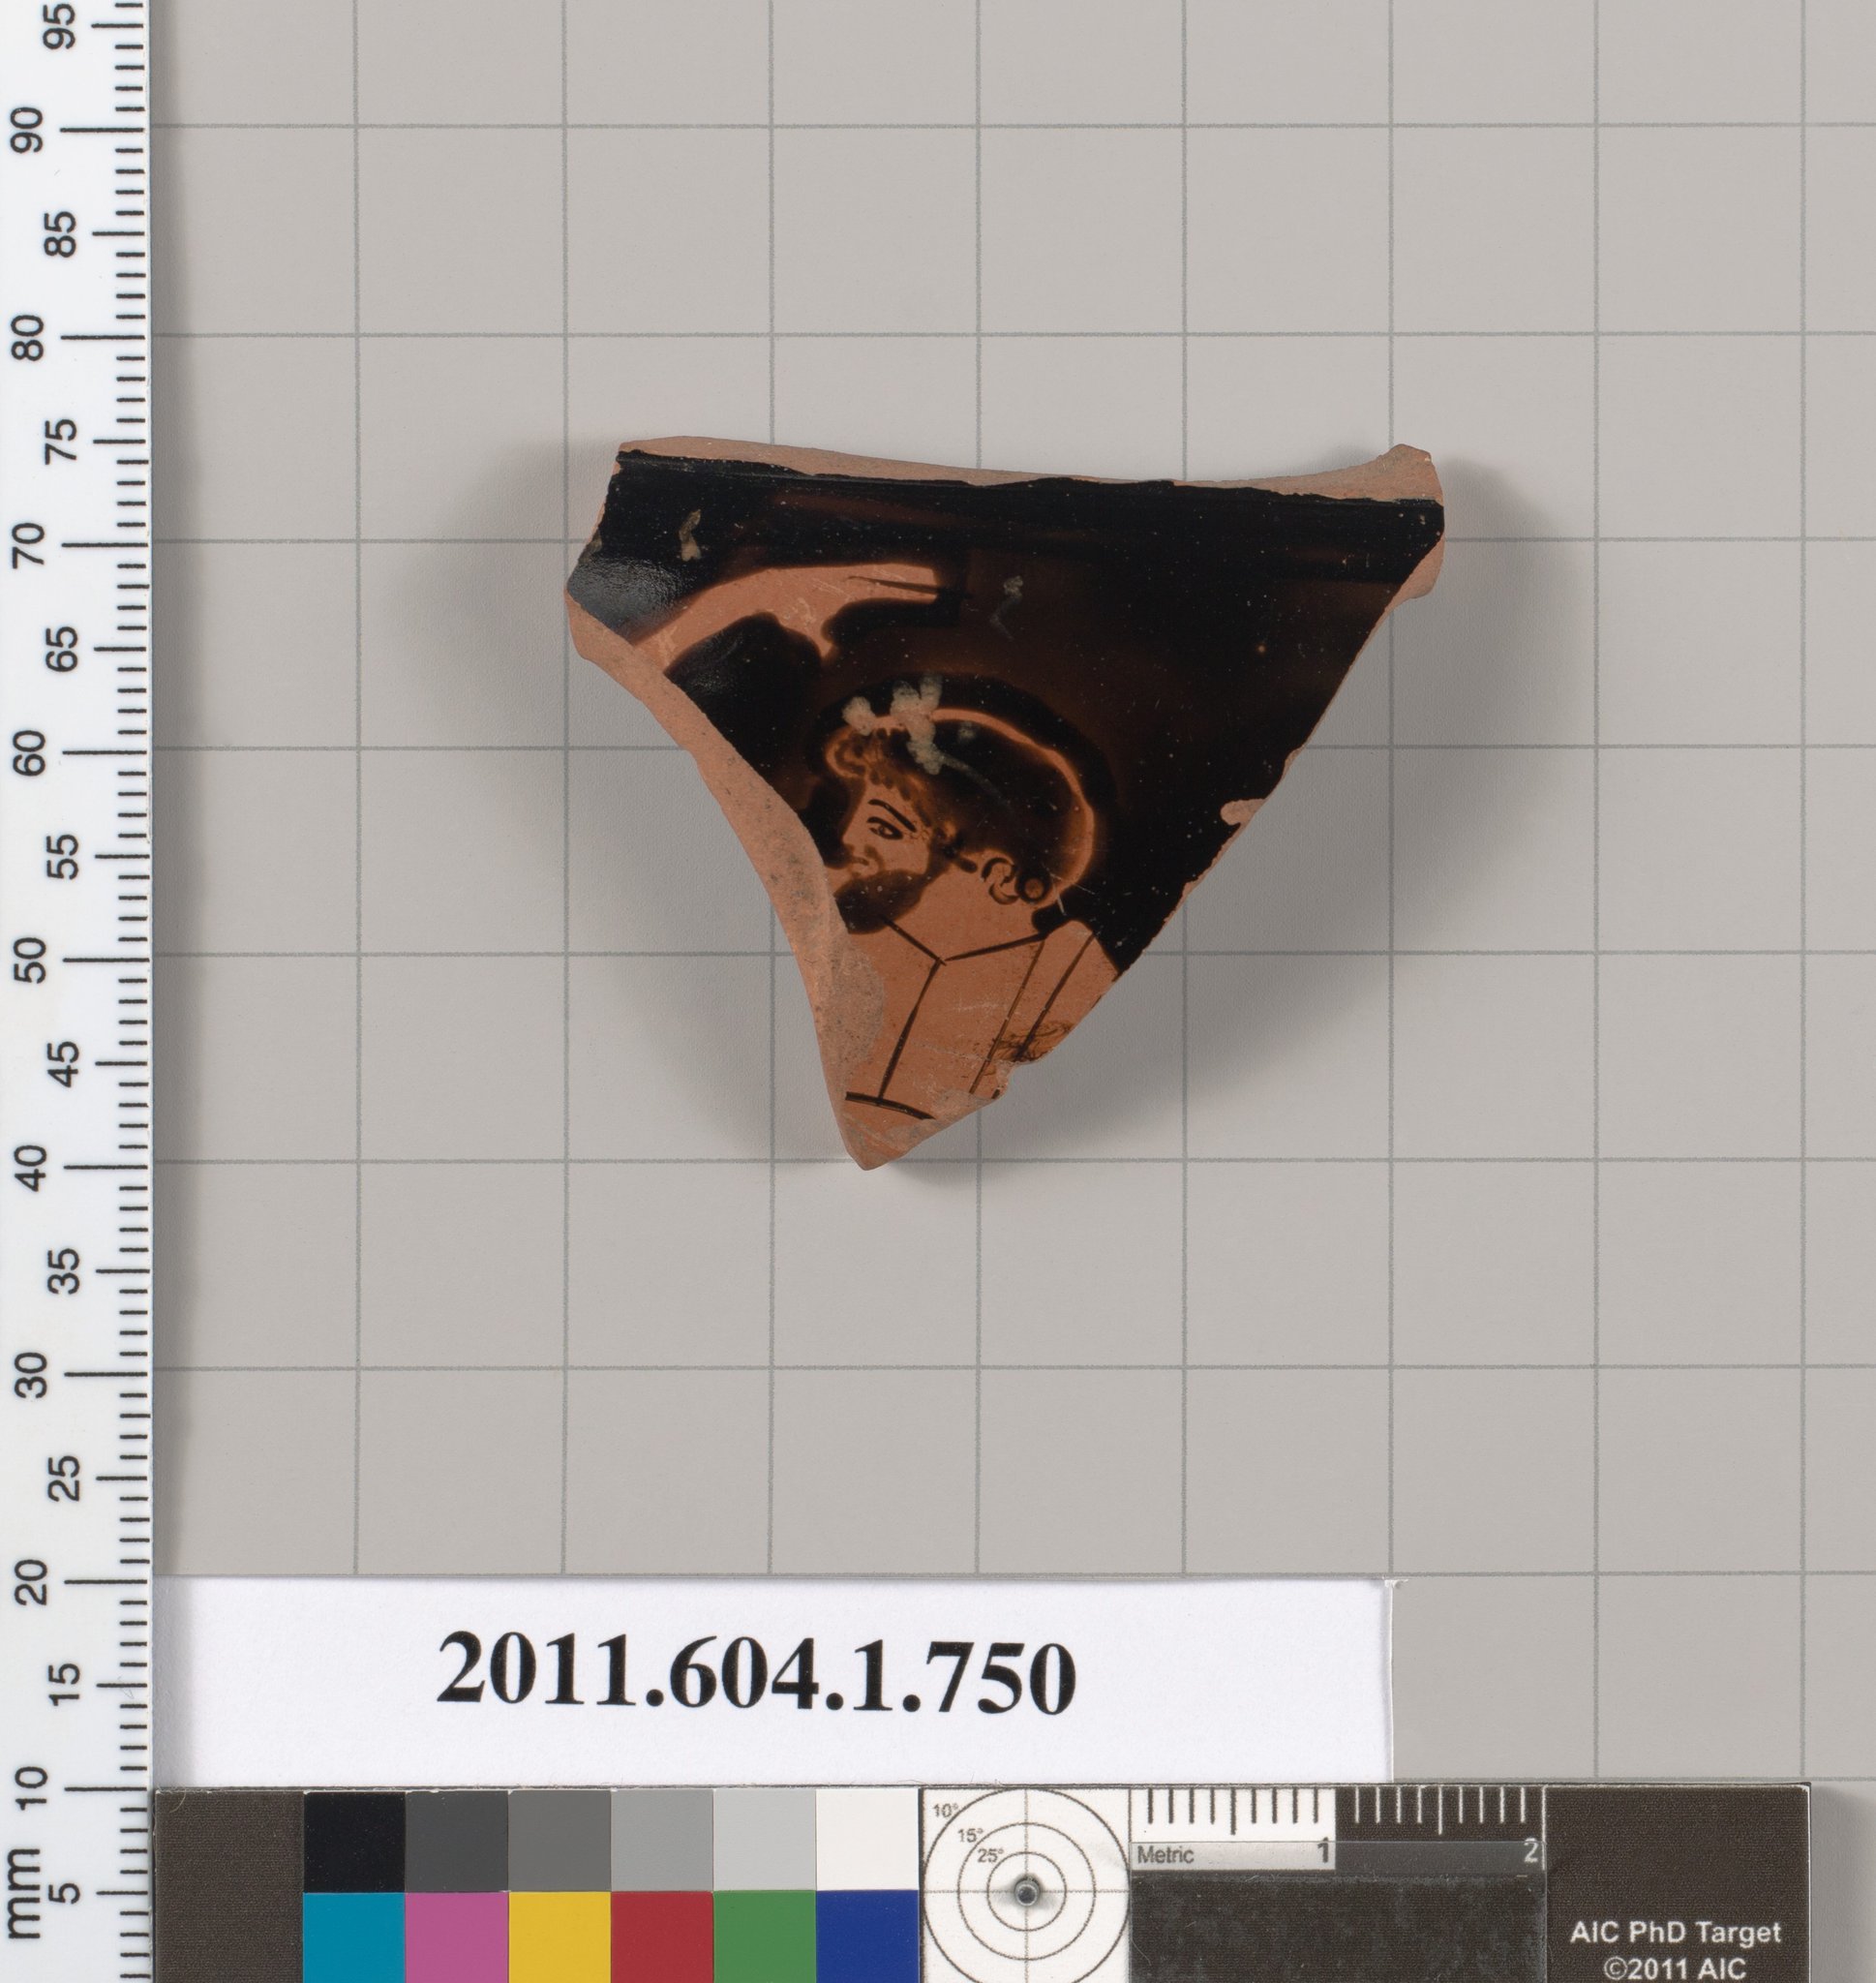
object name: kylix fragment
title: Terracotta fragment of a kylix (drinking cup)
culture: greek, attic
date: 490-480 BCE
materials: terracotta